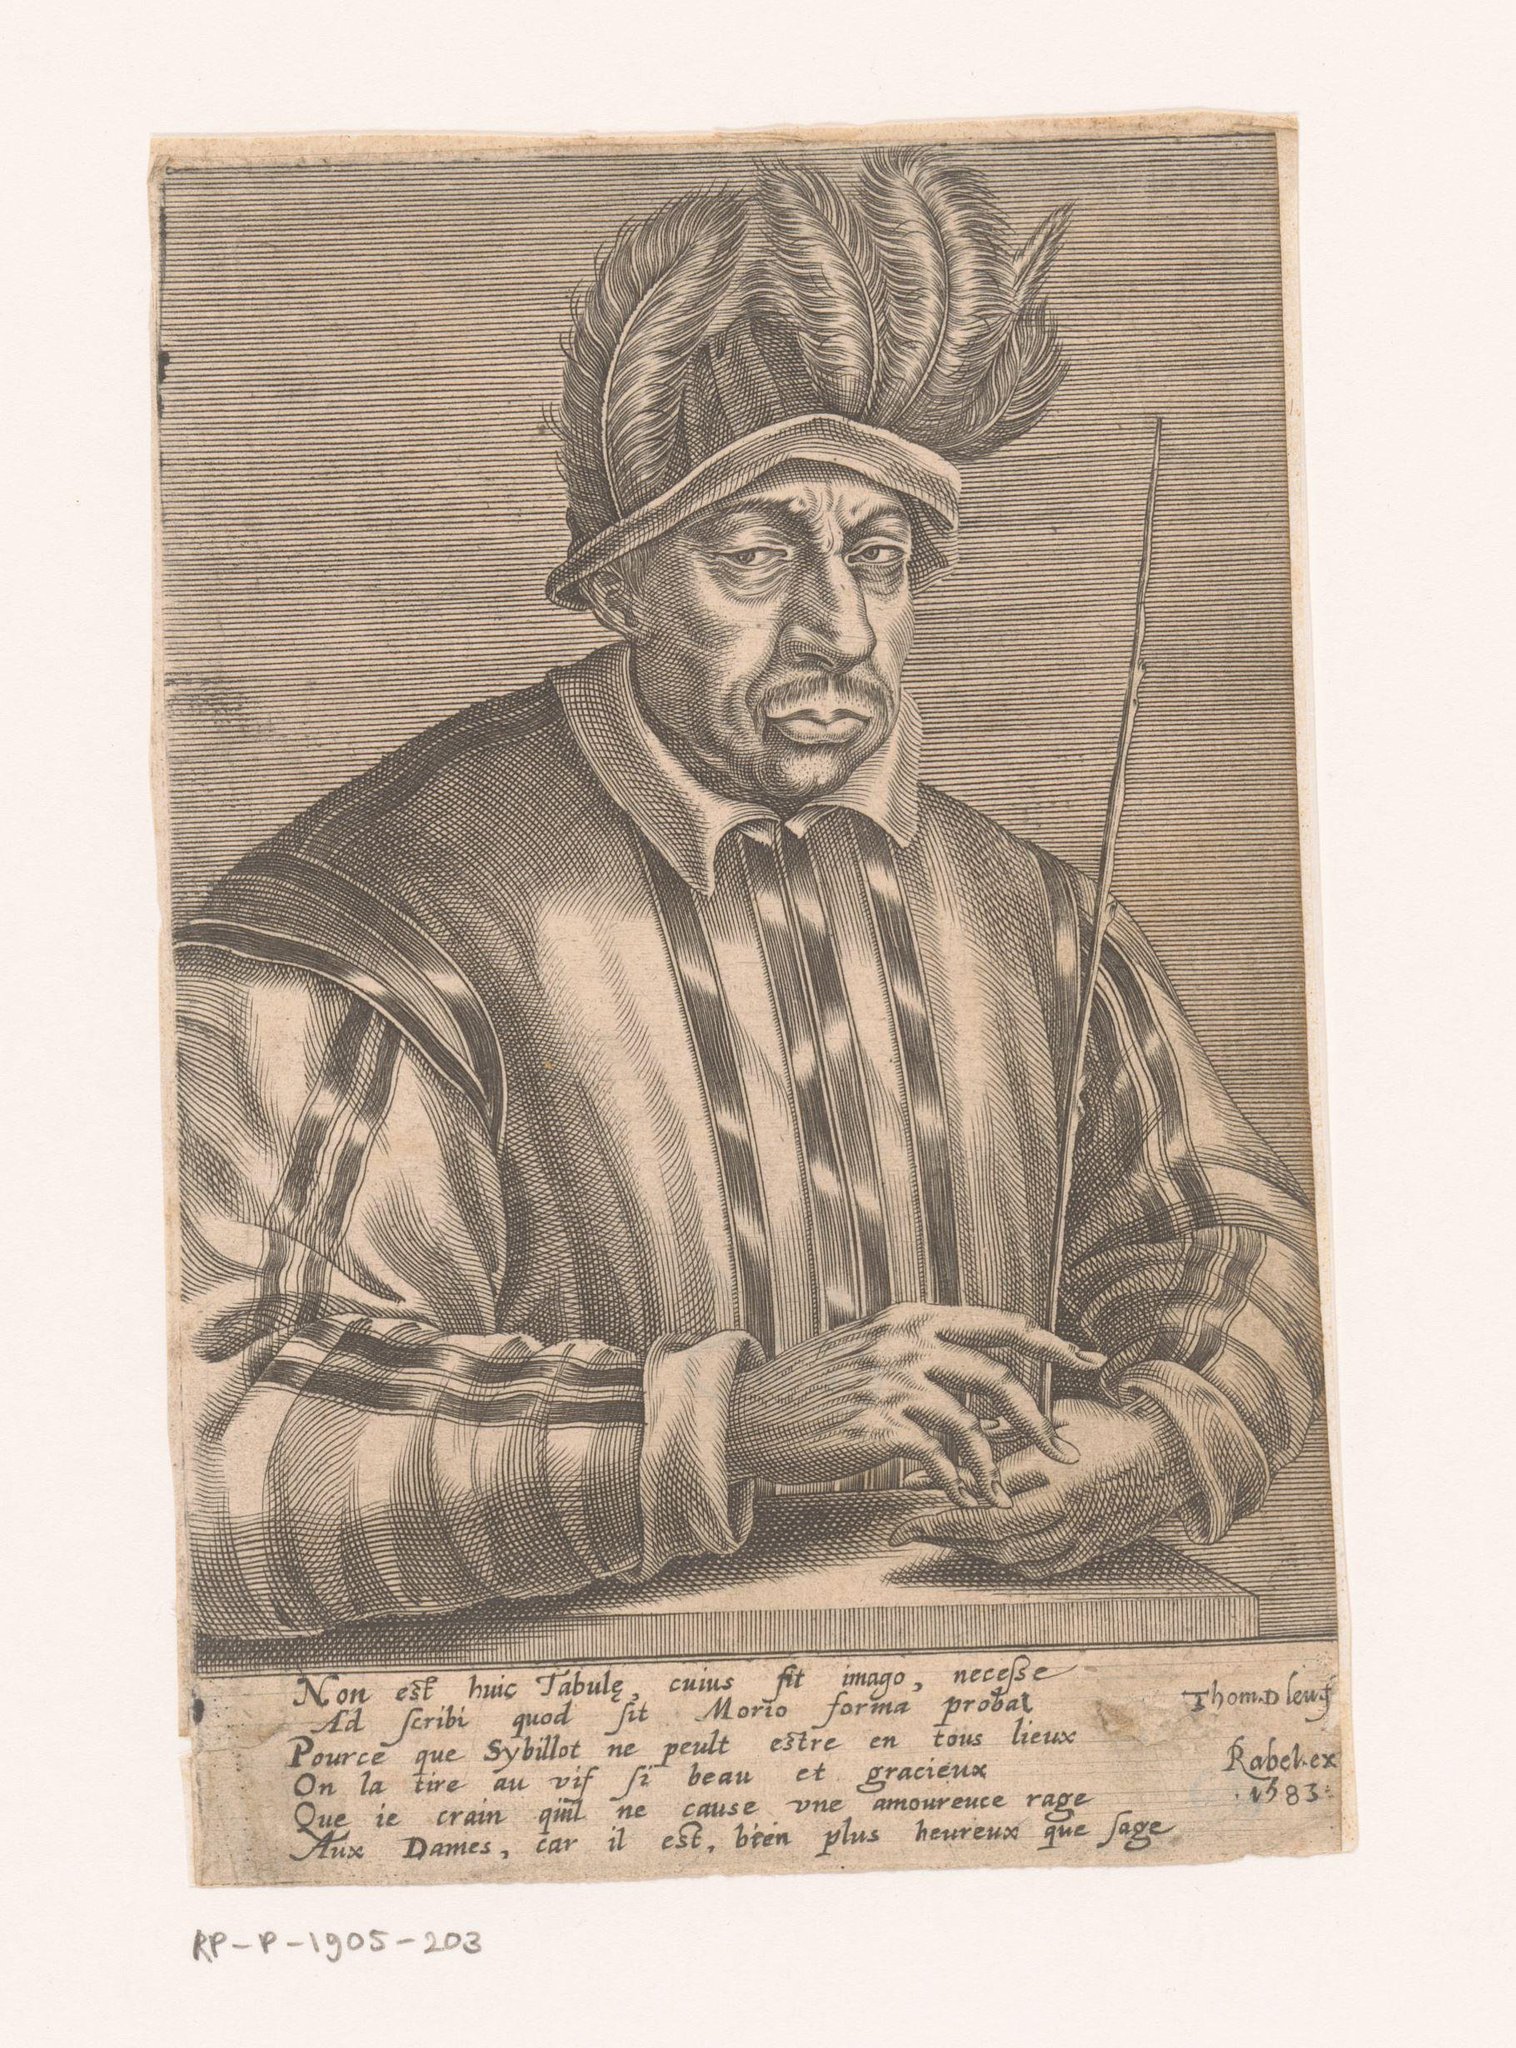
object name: print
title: Portret van Sybillot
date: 1583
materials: paper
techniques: engraving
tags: historical persons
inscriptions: collector's mark: Lugt 1337, collector's mark: Lugt 2228